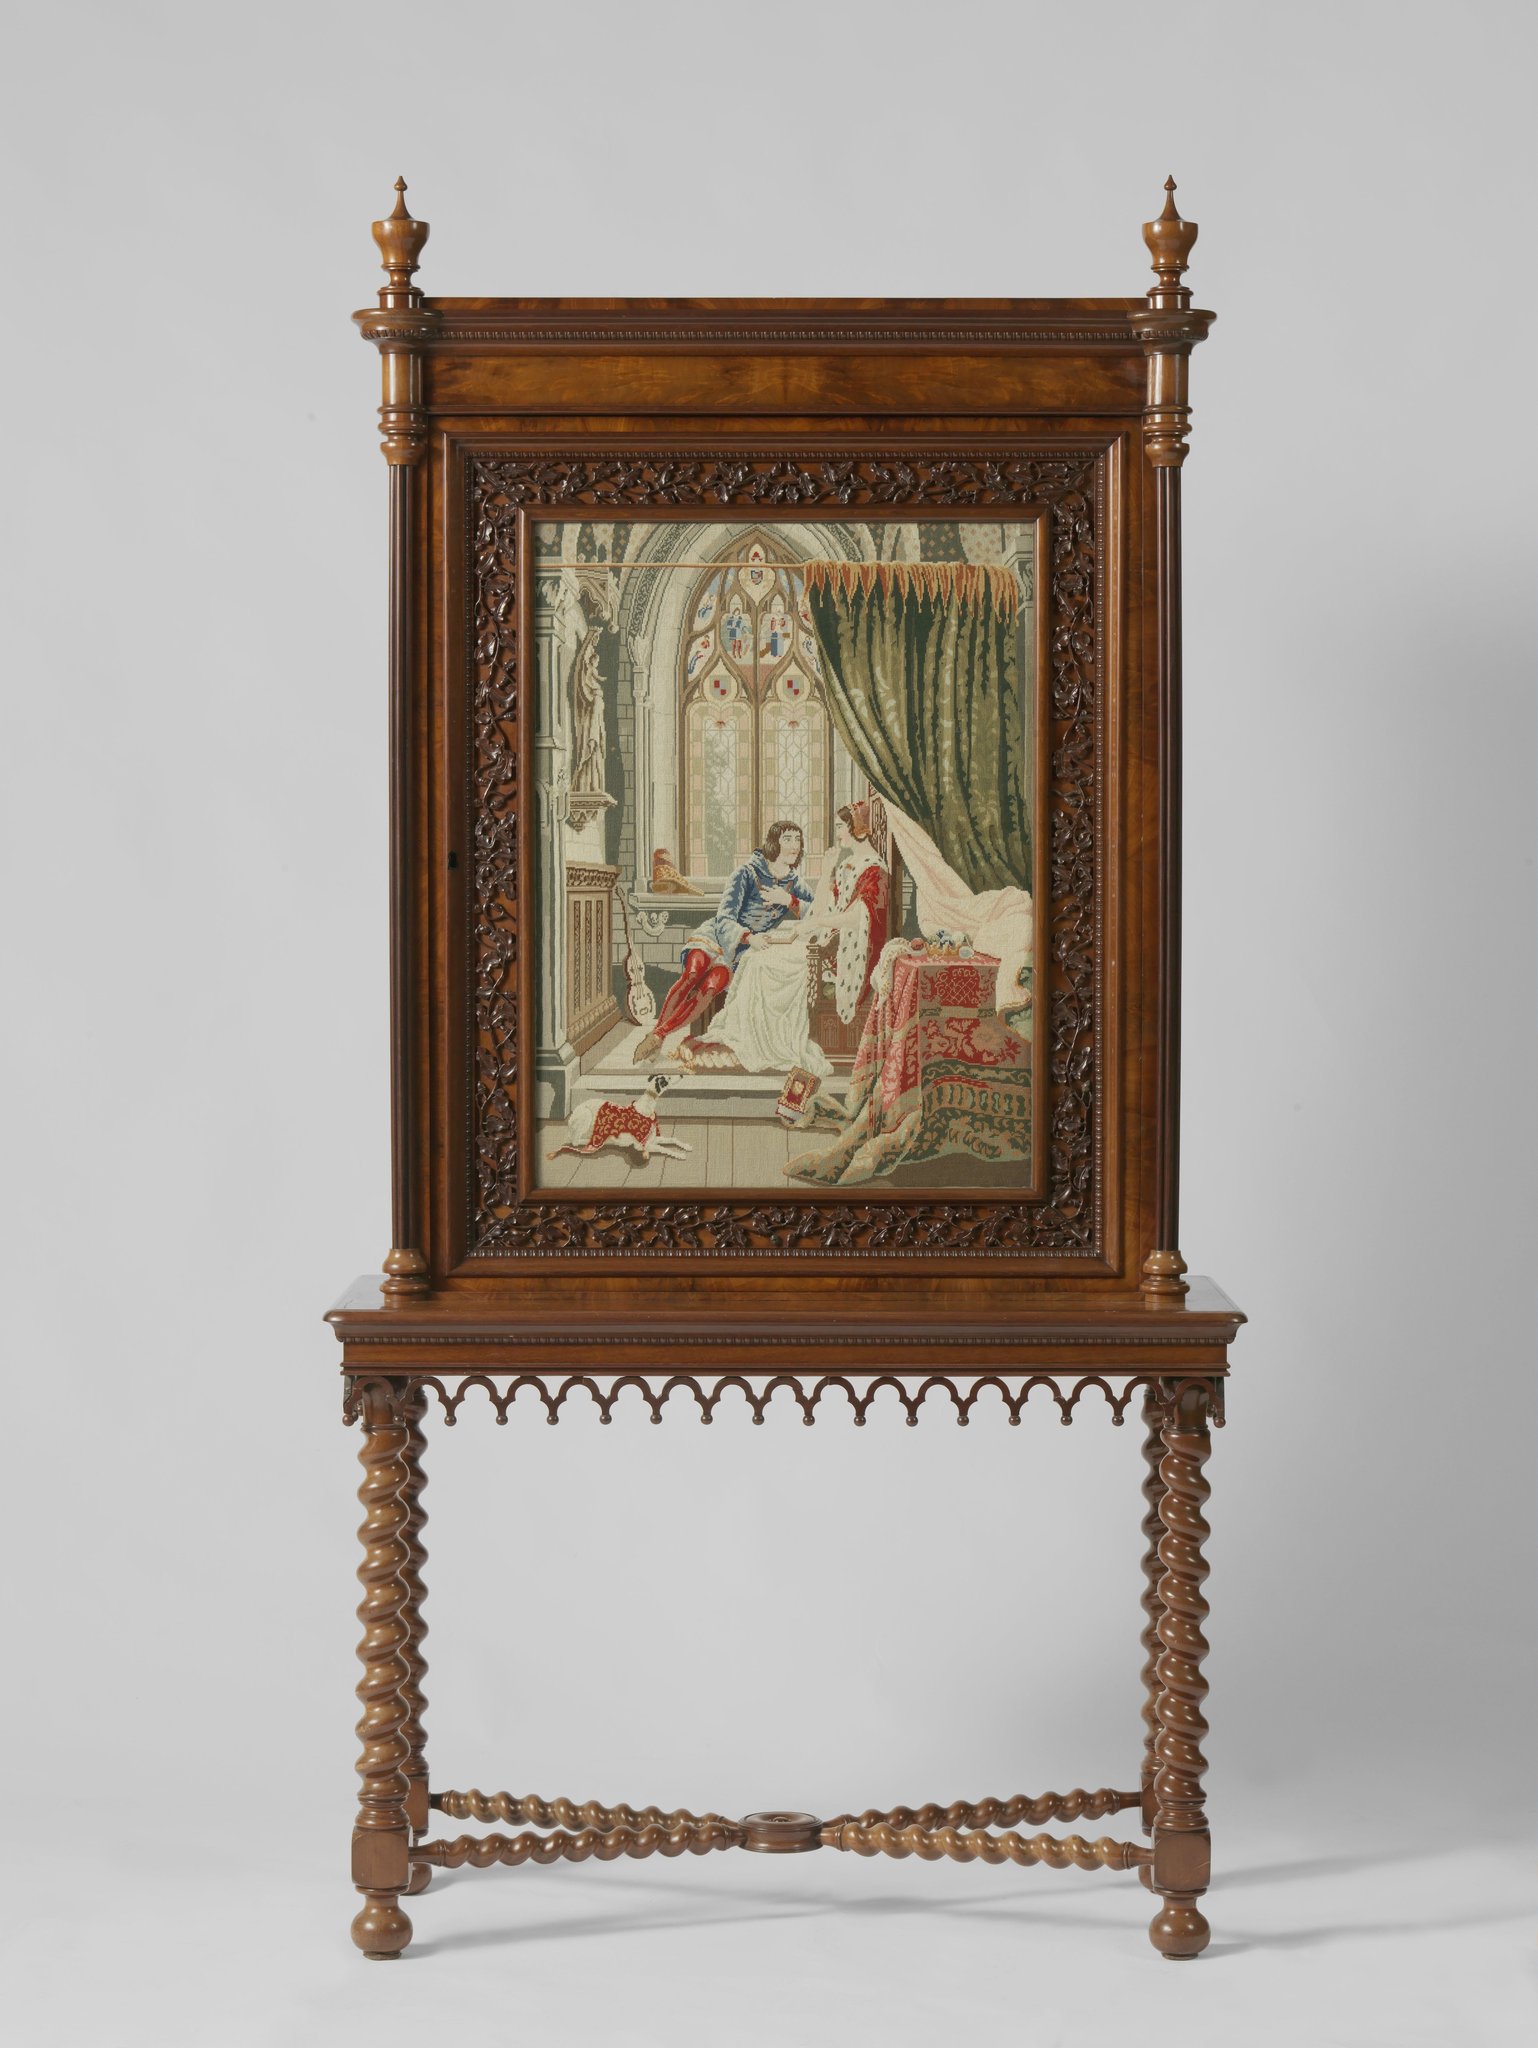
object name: bookcase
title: Neo-gothische boekenkast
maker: Anonymous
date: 1835-1845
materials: glass, wood, silk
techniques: embroidered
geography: netherlands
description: Neo-gothische boekenkast, ingelegd met een geborduurd paneel.